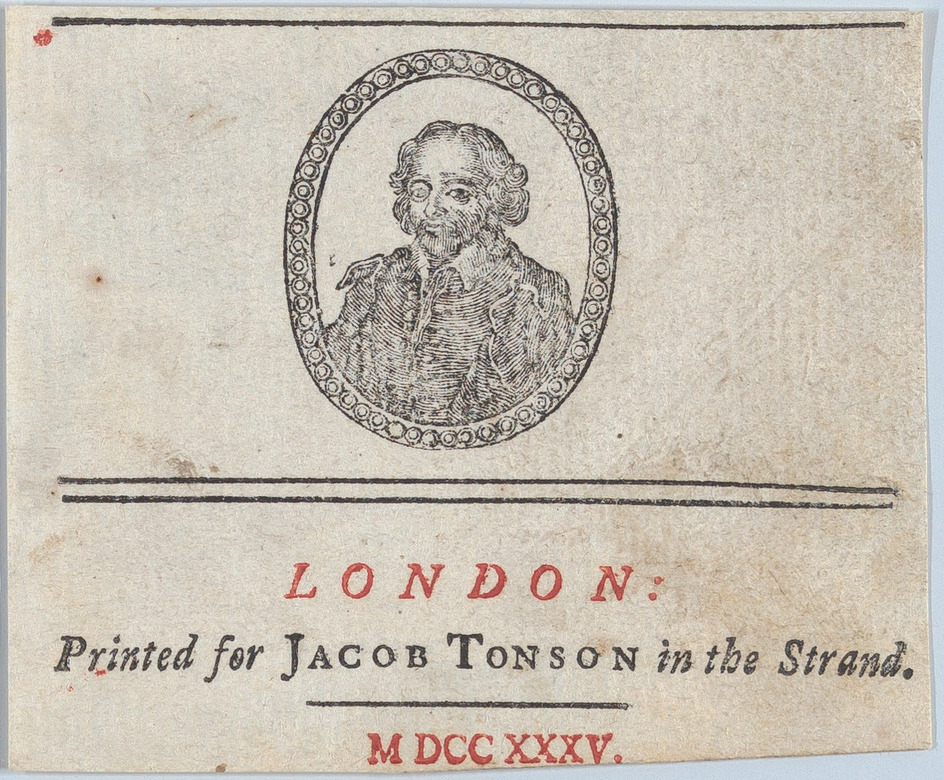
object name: print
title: Shakespeare's Head Emblem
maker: jacob tonson, the elder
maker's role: publisher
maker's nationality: british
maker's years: 1655-1736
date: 1735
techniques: letterpress, woodcut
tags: shakespeare